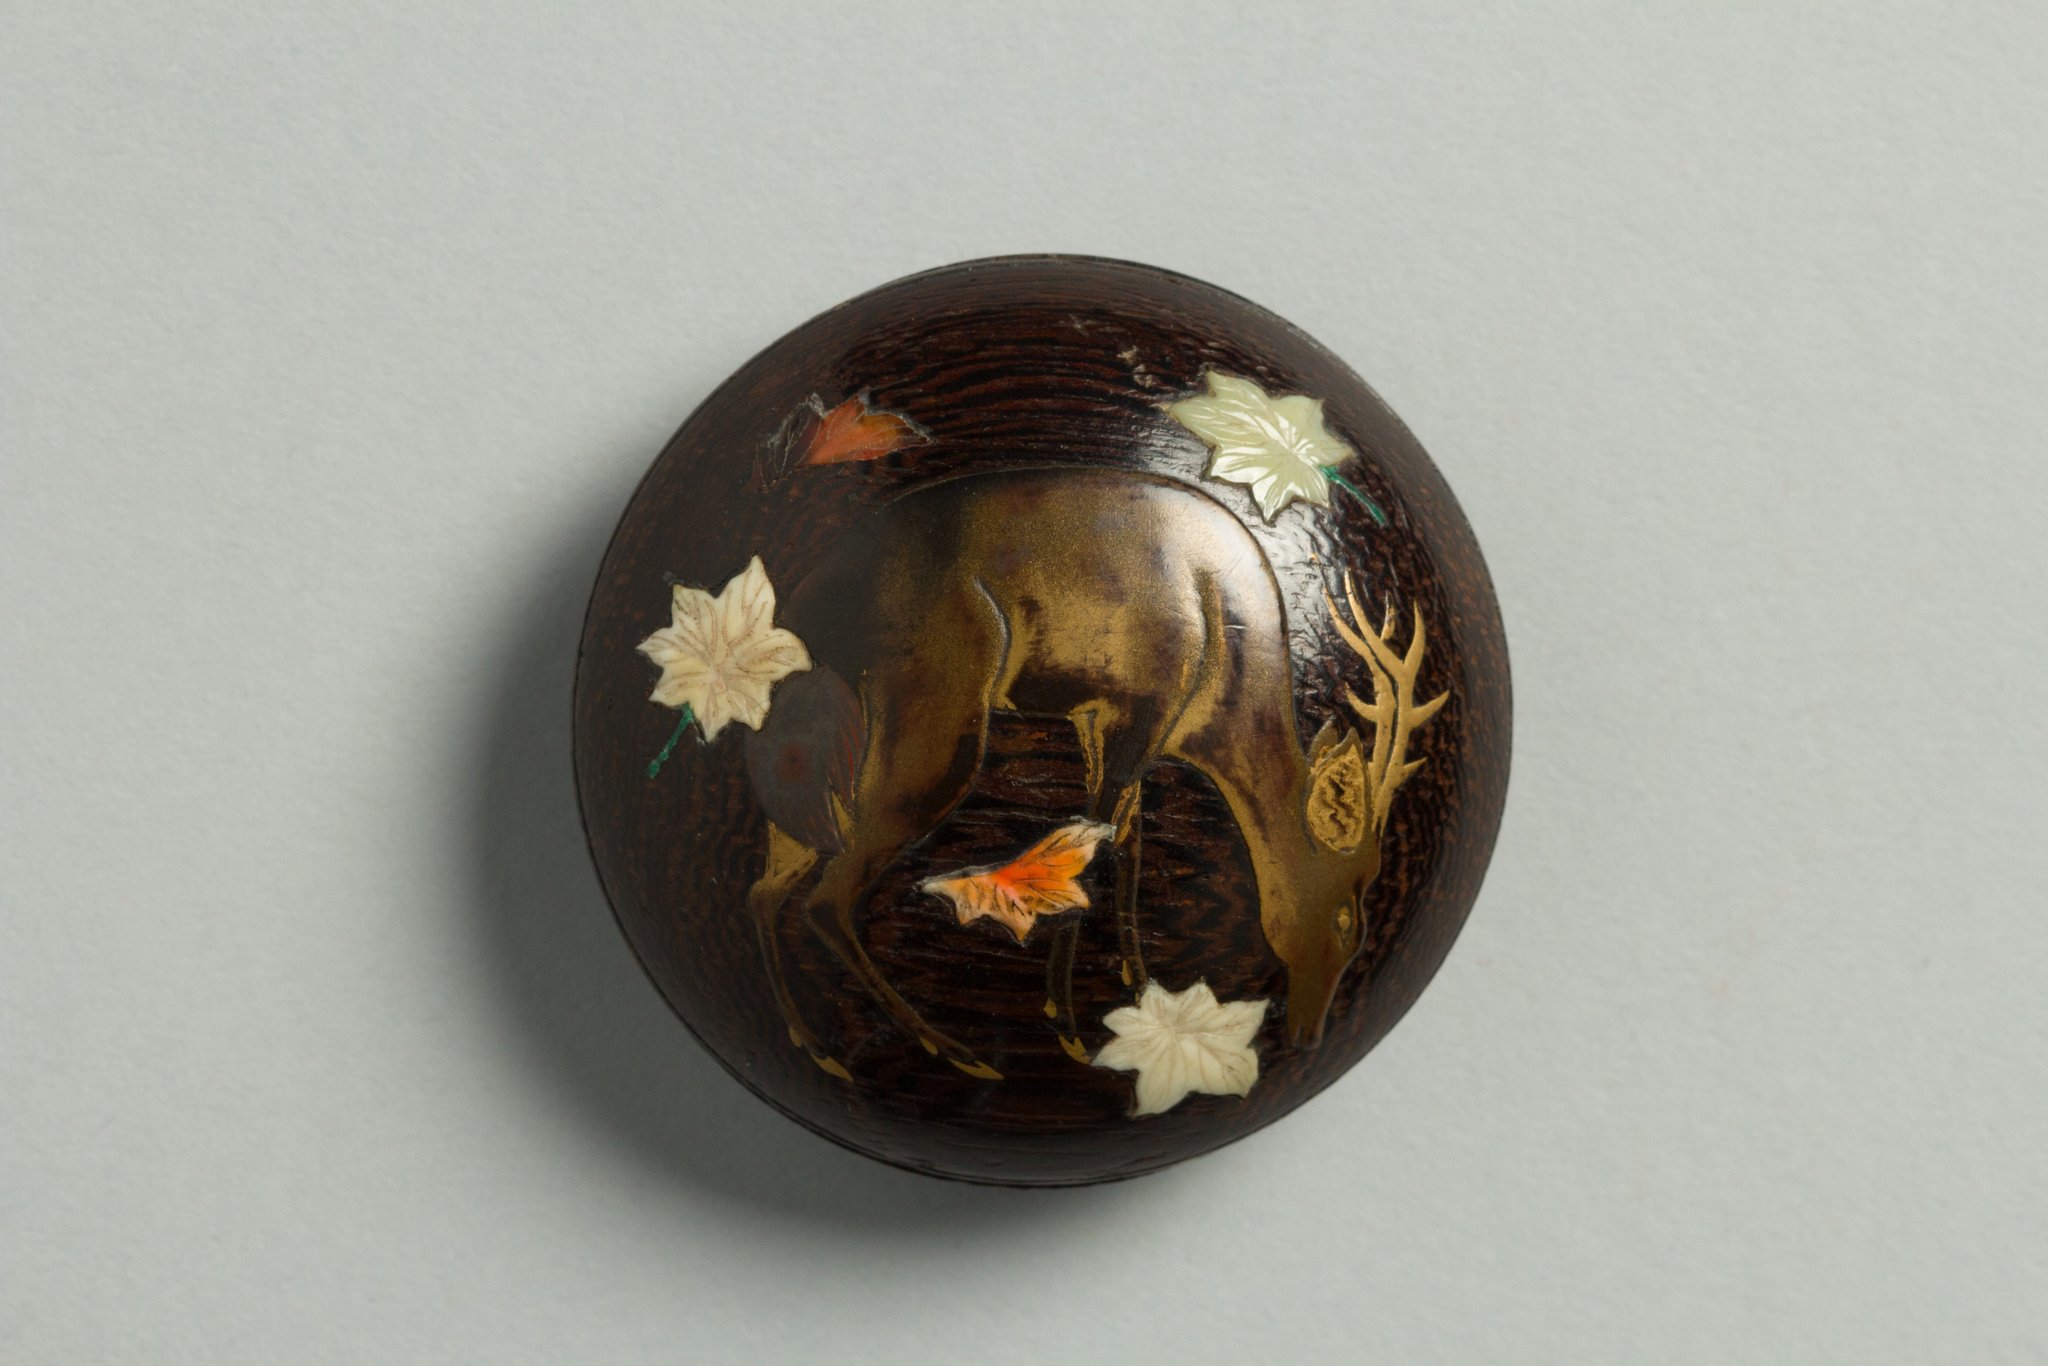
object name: netsuke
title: Netsuke with a Deer and Leaves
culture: japanese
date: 1801-1900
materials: gold, ivory, lacquer, wood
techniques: inlay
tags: deer